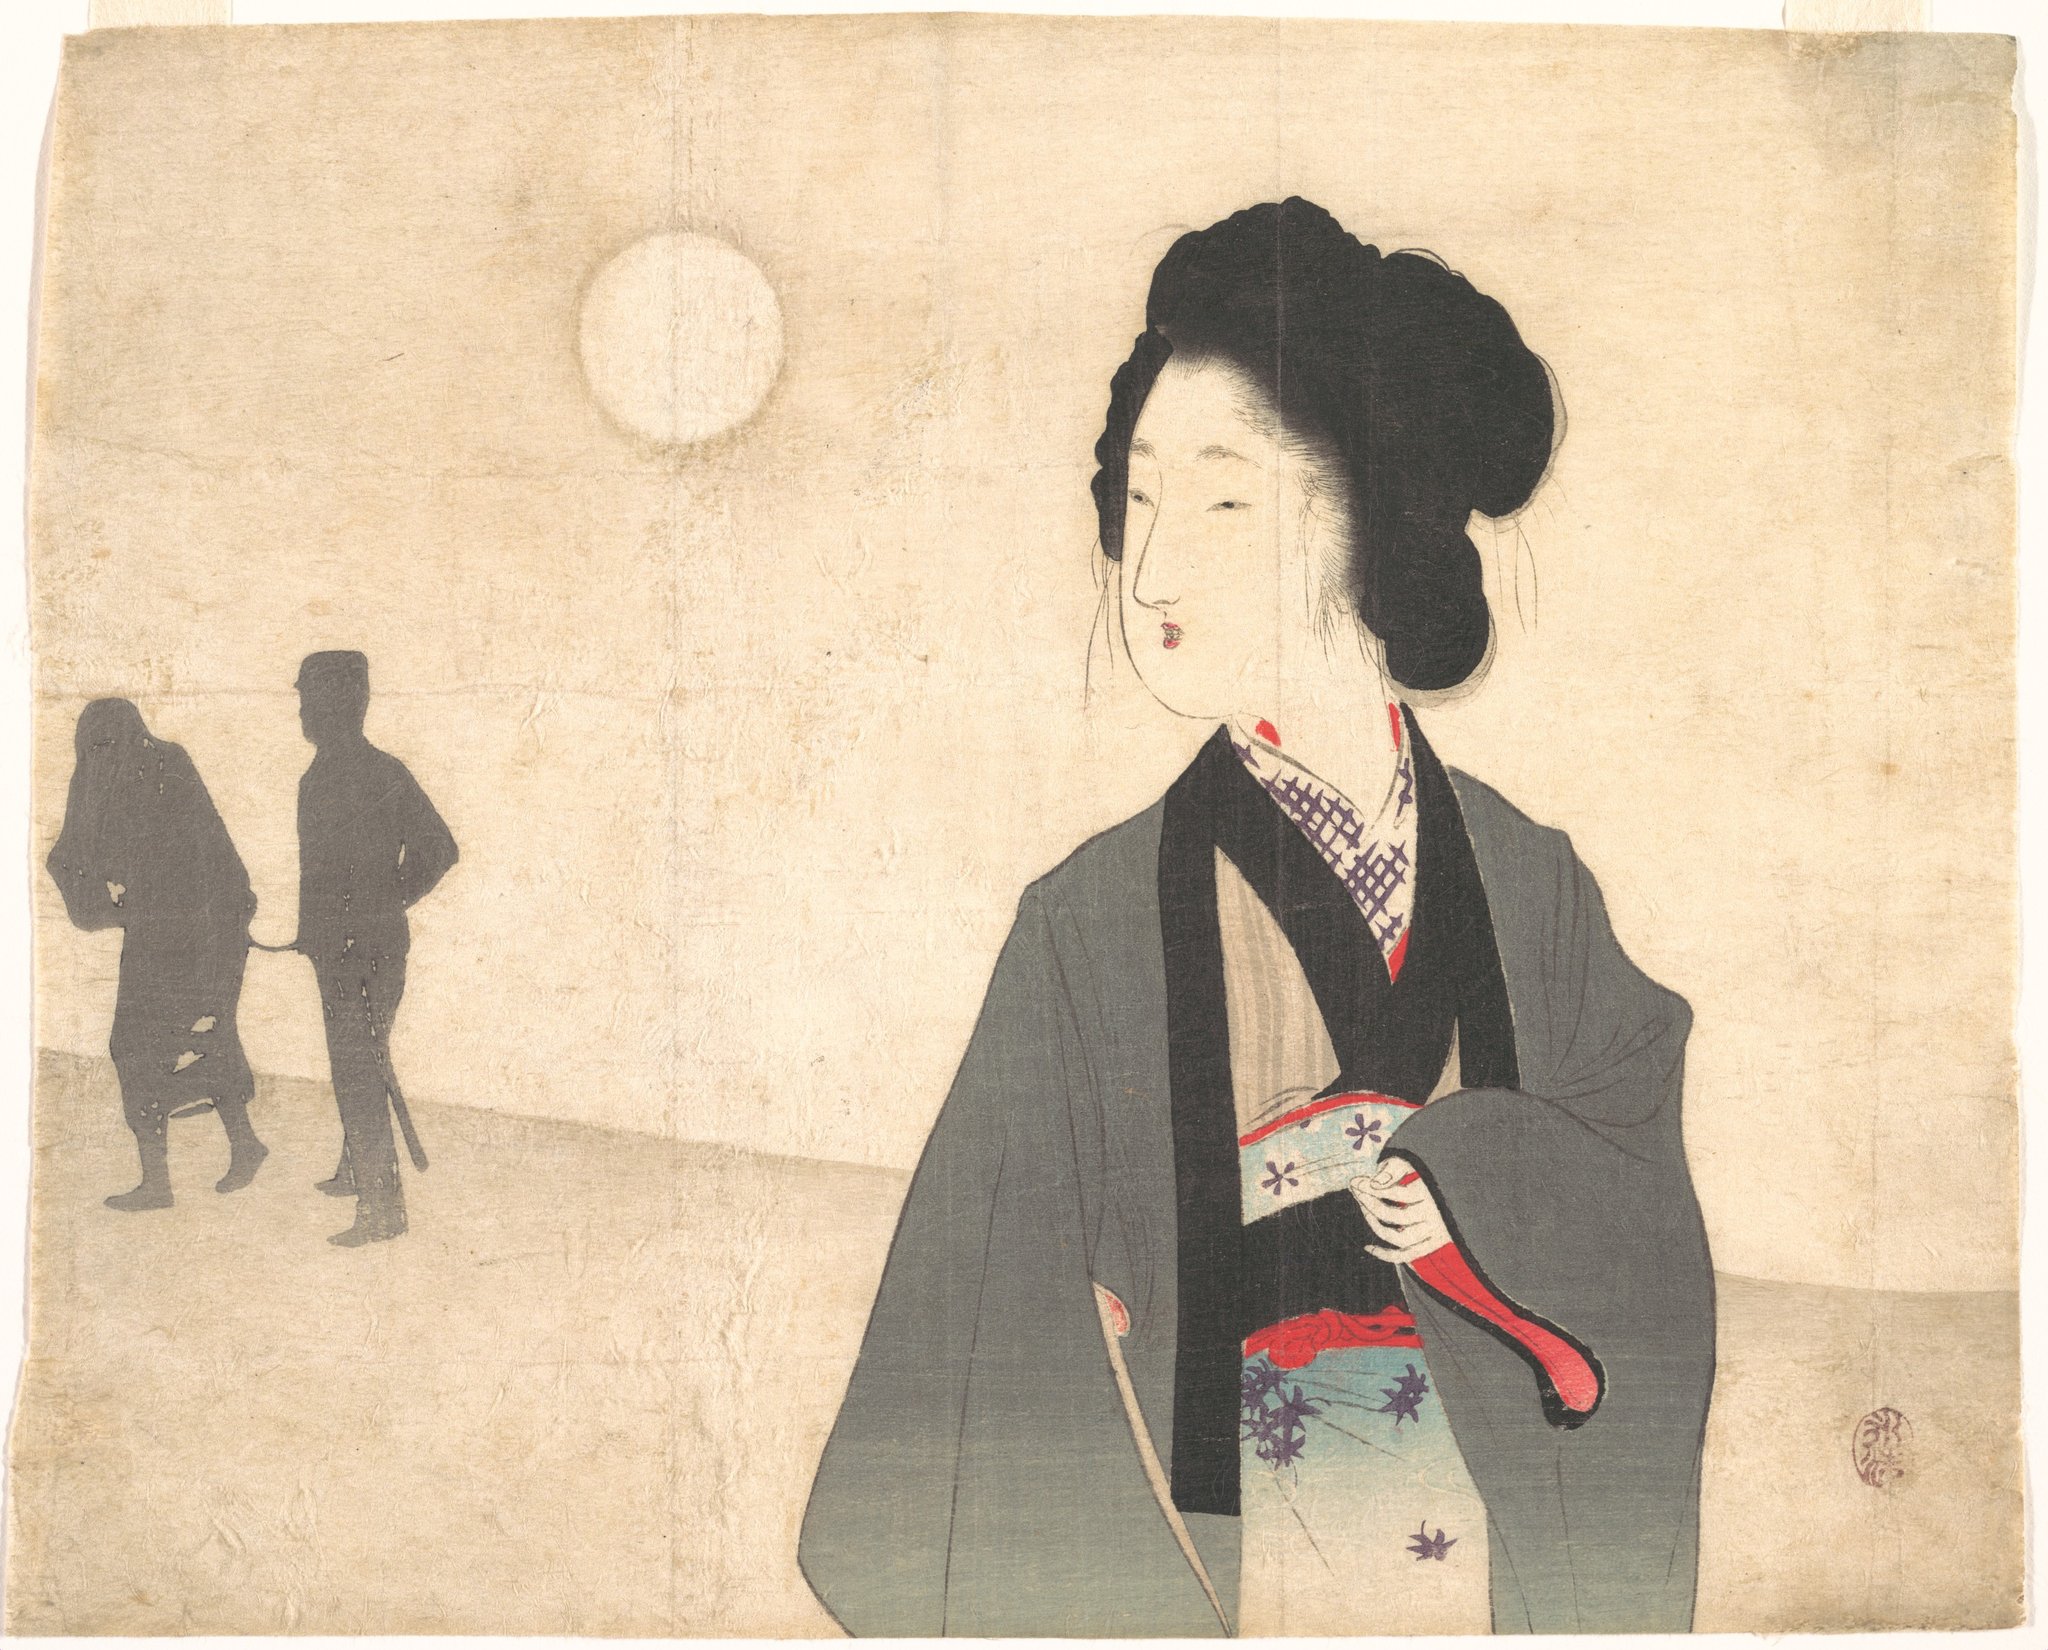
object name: print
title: Young Woman Looks at Silhouette of a Male Prisoner being Led Away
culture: japanese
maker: tomioka eisen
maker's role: artist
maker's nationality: japanese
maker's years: 1864-1905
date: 1901-1933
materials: ink, paper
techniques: woodblock print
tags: prisoners,men,women